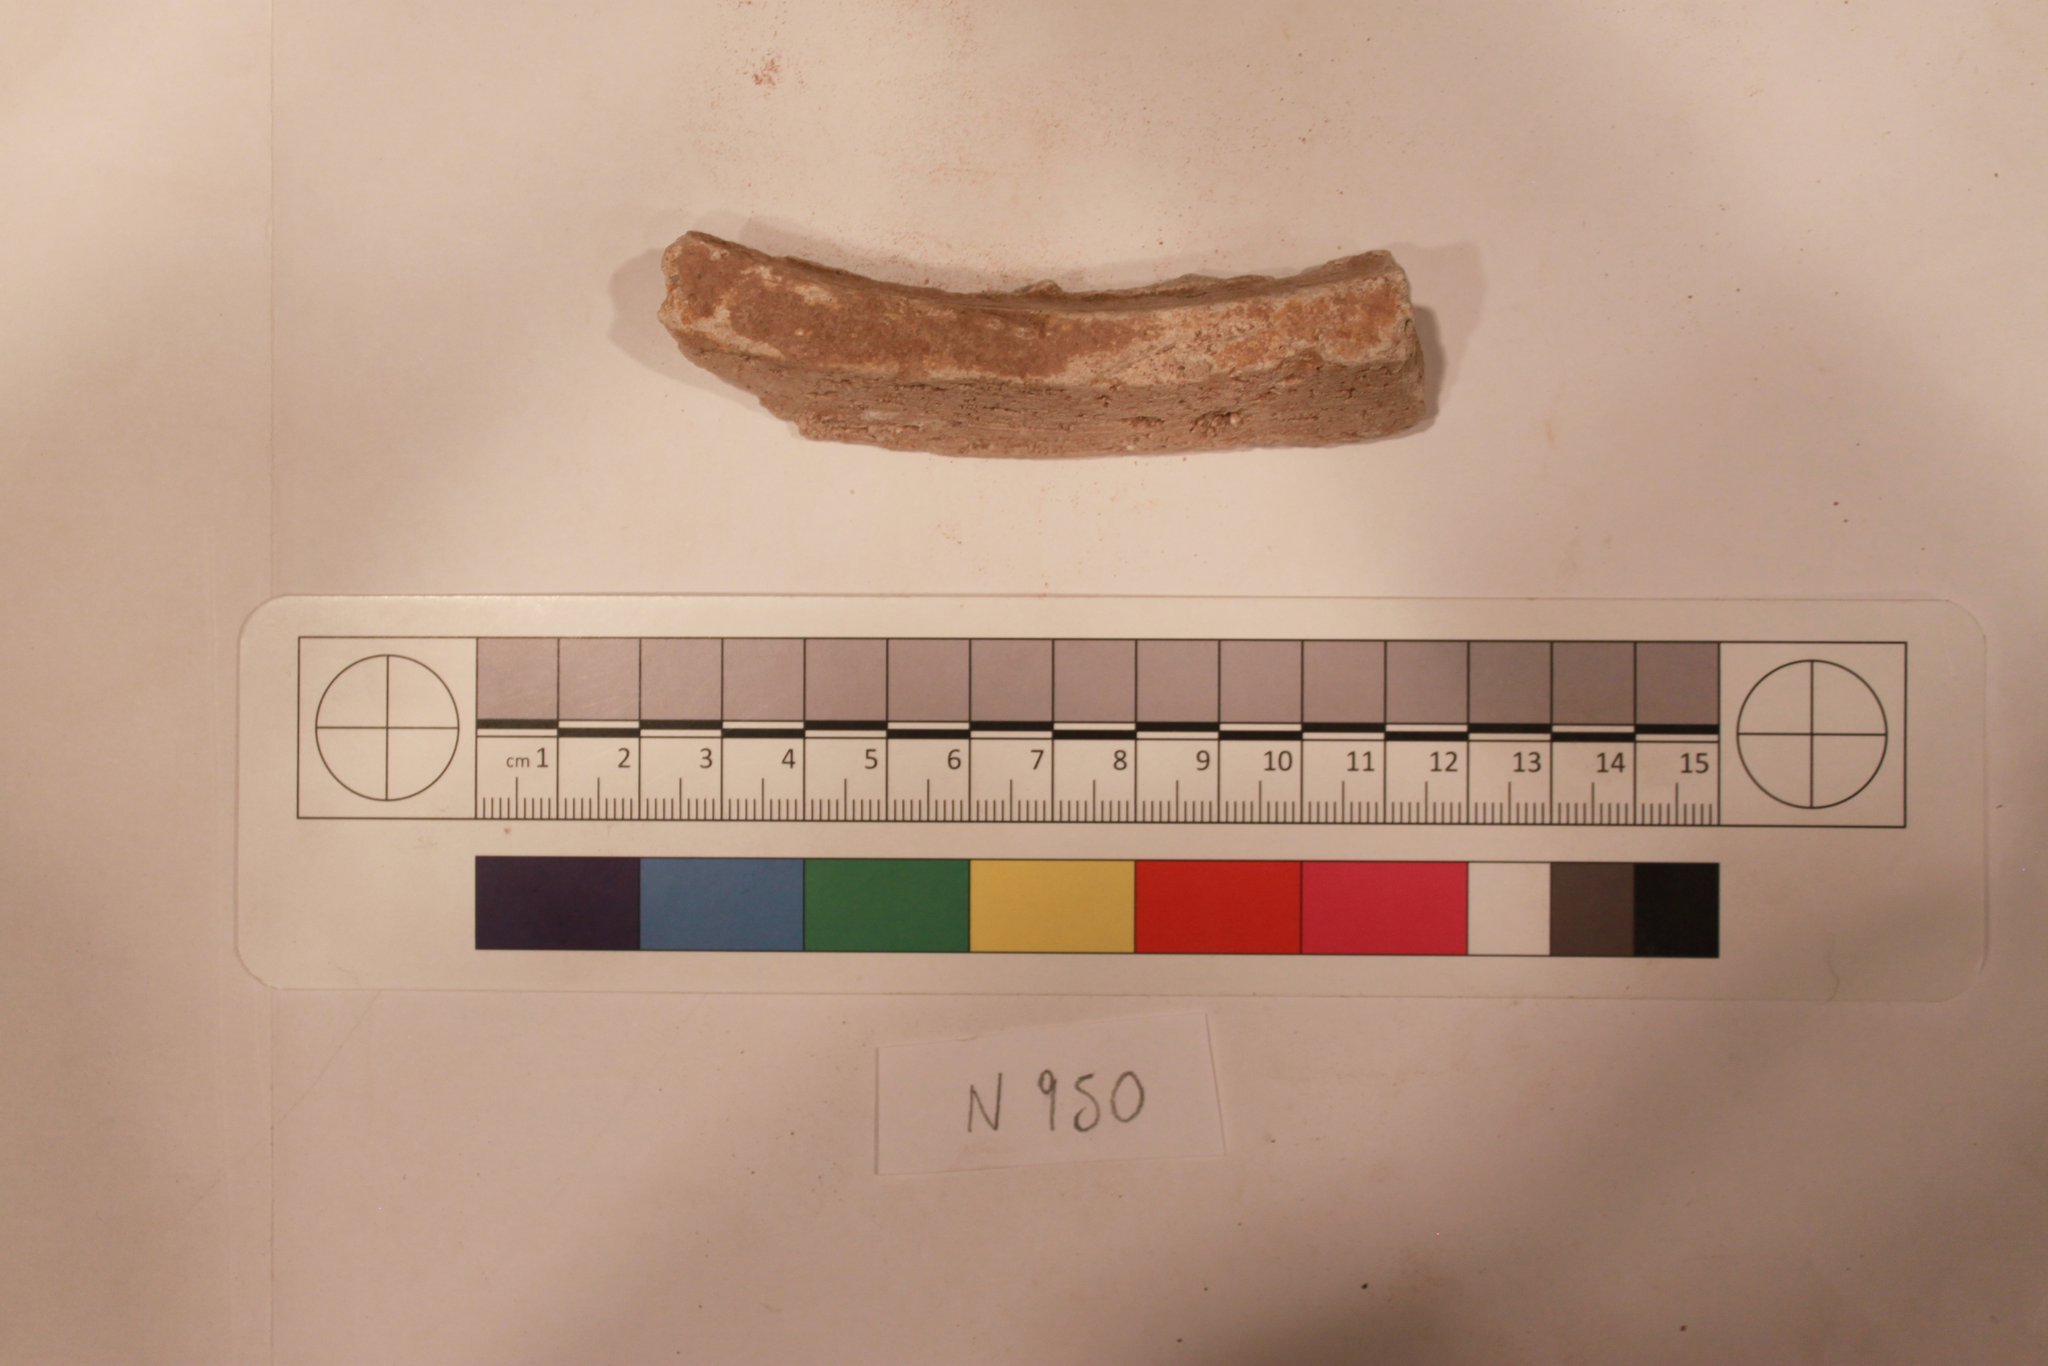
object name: fragment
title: Stucco Fragment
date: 701-1200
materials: plaster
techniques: carving, painting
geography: iran